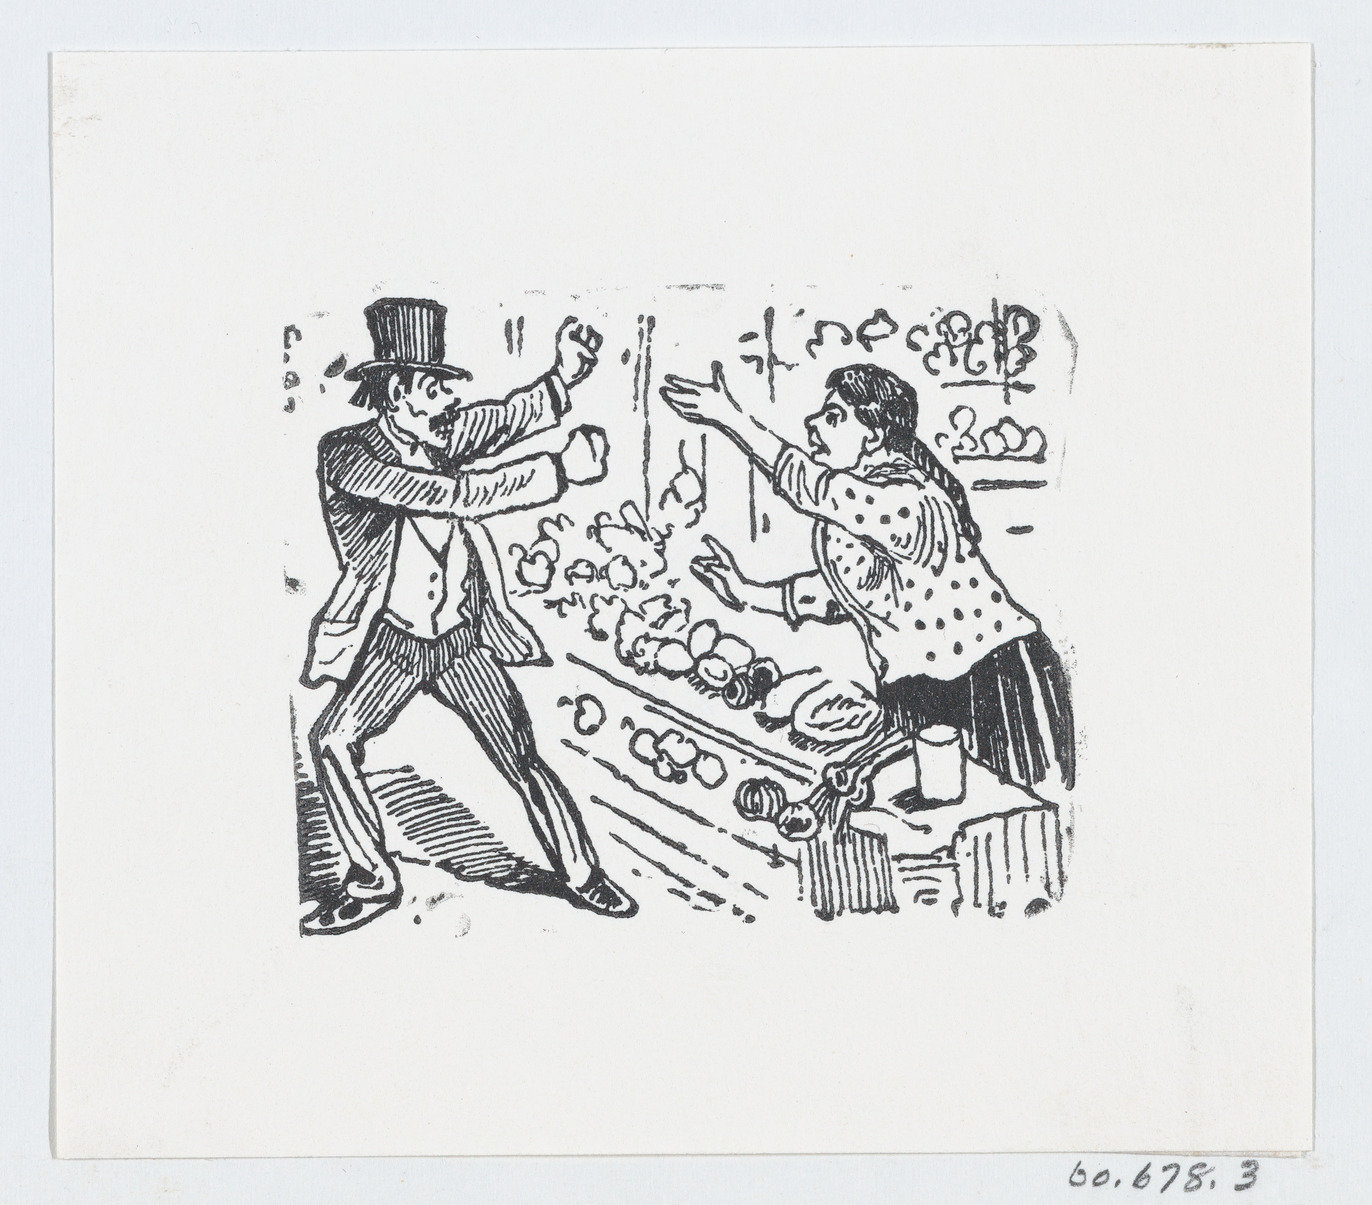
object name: print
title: A woman yelling at a man with his arms raised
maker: josé guadalupe posada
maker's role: artist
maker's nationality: mexican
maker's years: 1852-1913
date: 1880-1910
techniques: lithography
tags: men,women